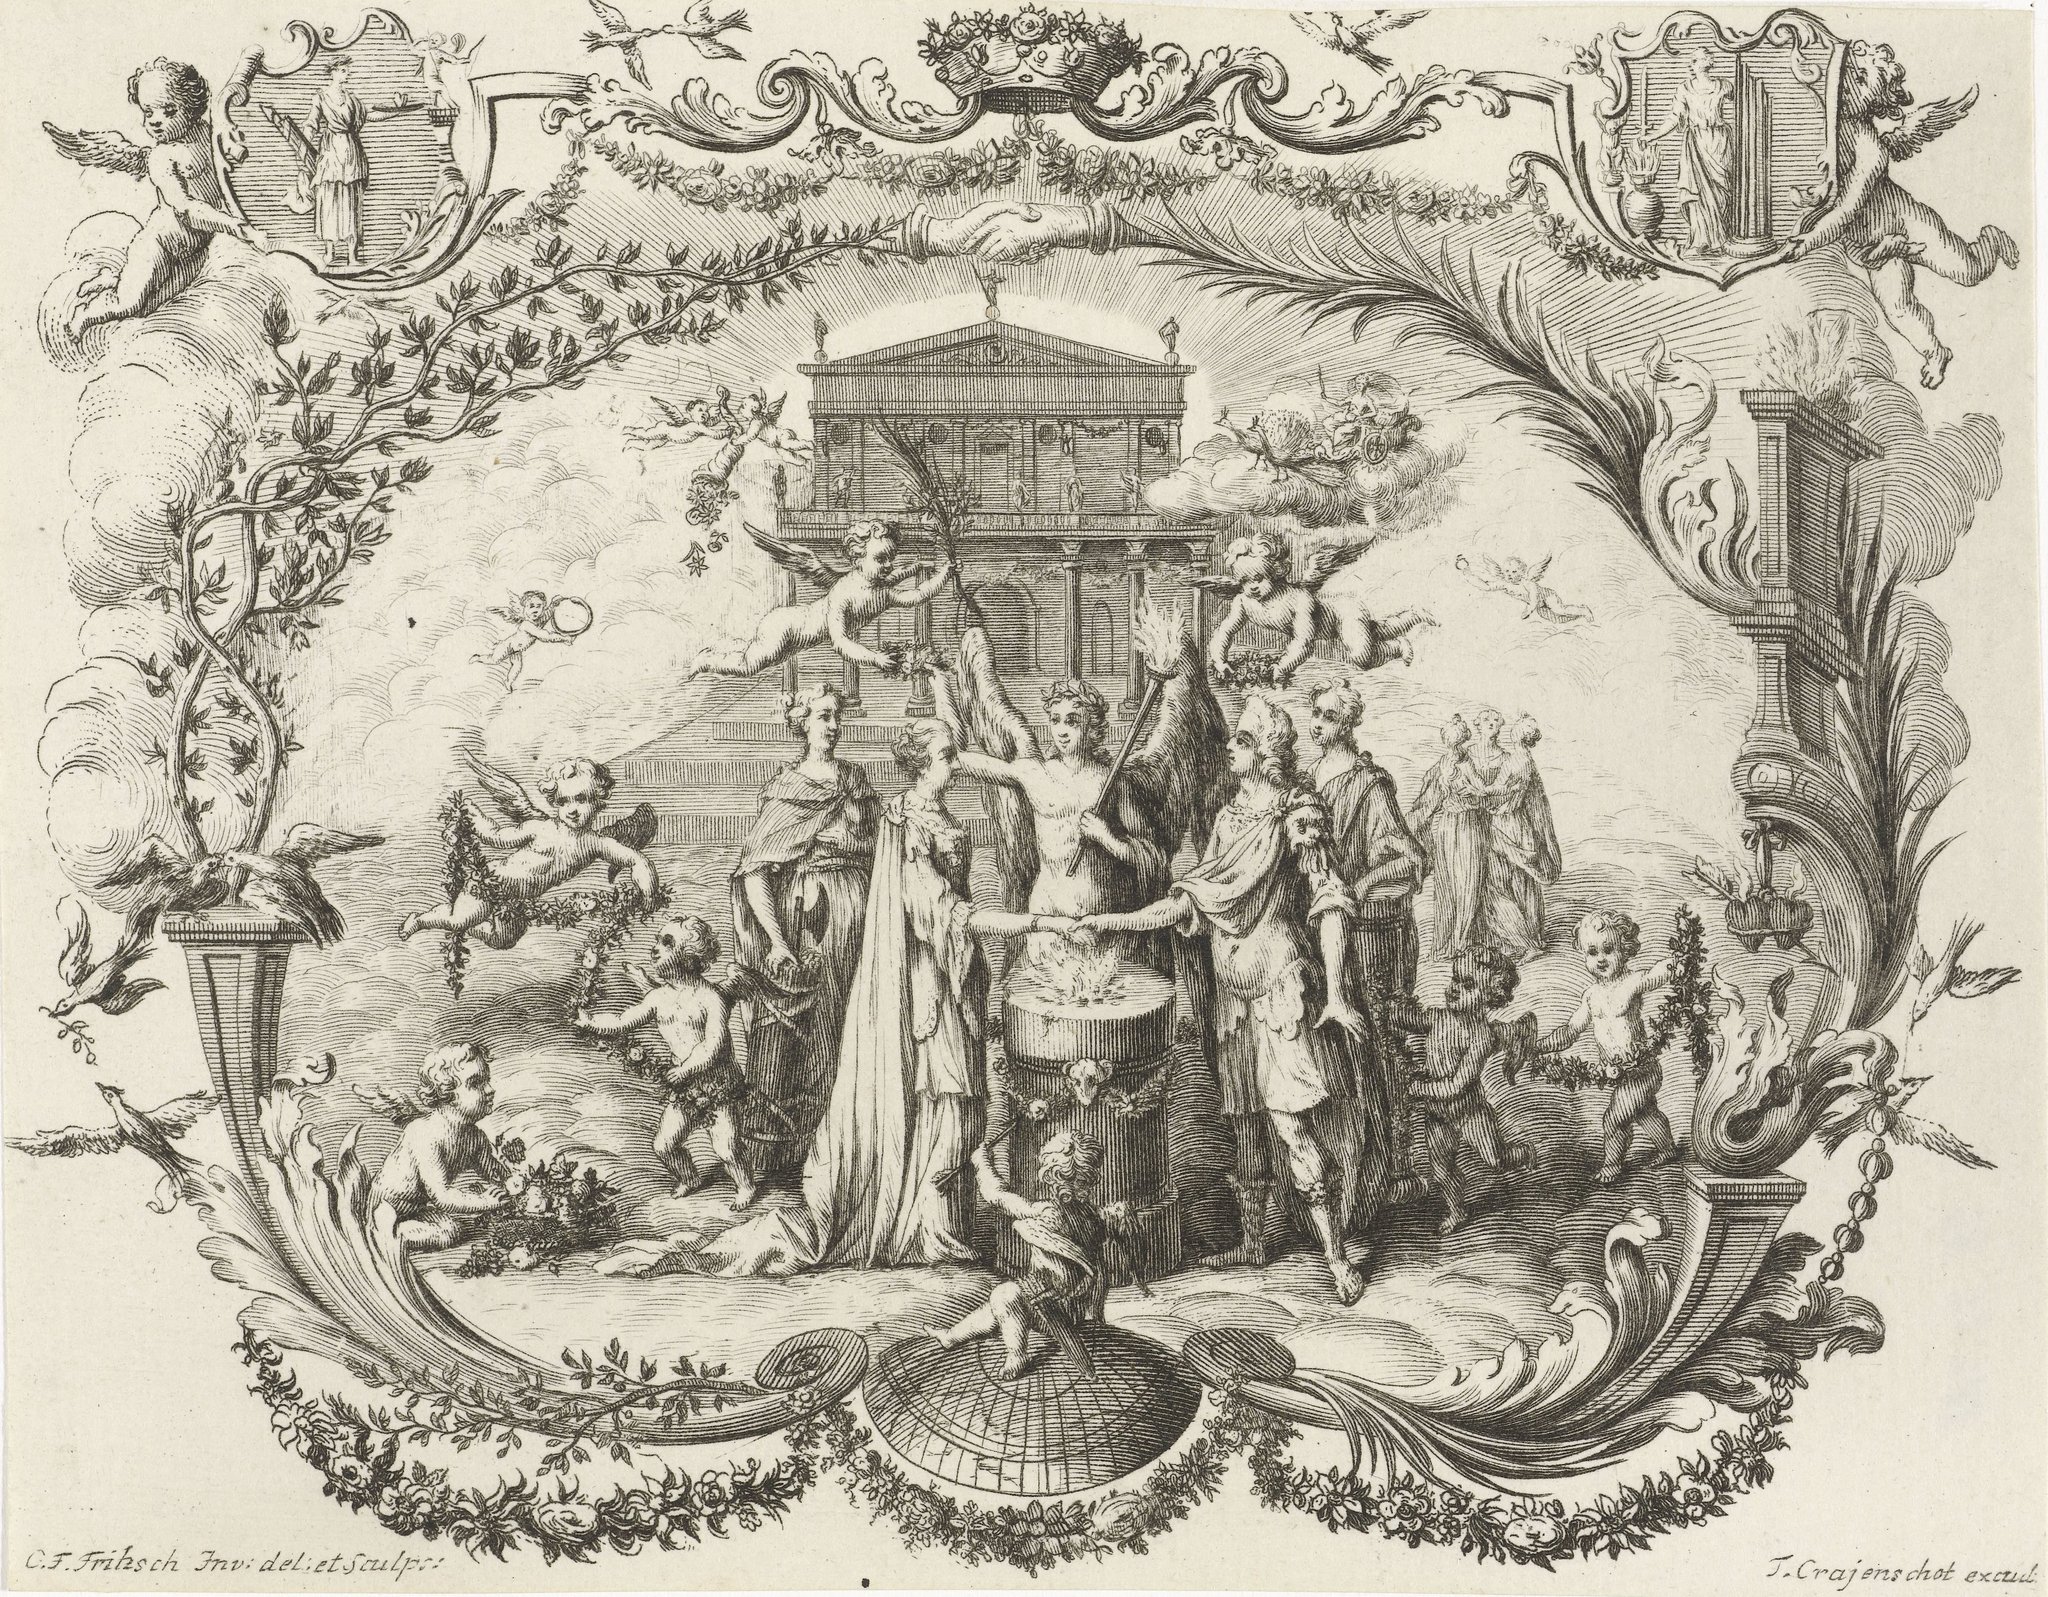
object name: print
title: Allegorie op het huwelijk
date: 1745-1800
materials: paper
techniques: etching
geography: amsterdam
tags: cupids: 'amores', 'amoretti', 'putti', 'castità matrimoniale', 'fede maritale', 'matrimonio' (ripa)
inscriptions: collector's mark: Lugt 240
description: Allegorie op het huwelijk, geplaatst in een sierlijk cartouche dat is opgebouwd uit bloemen, planten en architectonische fragmenten. Centaal in de voorstelling worden een man en vrouw door een engel in de echt verbonden en gelauwerd door twee putti. Hun handen raken elkaar boven een brandend offerzuil. Het paar wordt bijgestaan door allegorische figuren en putti met bloemguirlandes. In de verte staat een klassiek gebouw waar putti met een hoorn des overvloeds en het eeuwigheidssymbool, de slang die zich in eigen staart bijt, rondvliegen. Rechts wordt Juno door pauwen in de lucht voortgetrokken in haar wagen. Onderin de cartouche zit Amor met pijl en boog op een schelp, links- en rechtsboven houden twee putti een cartouche vast.